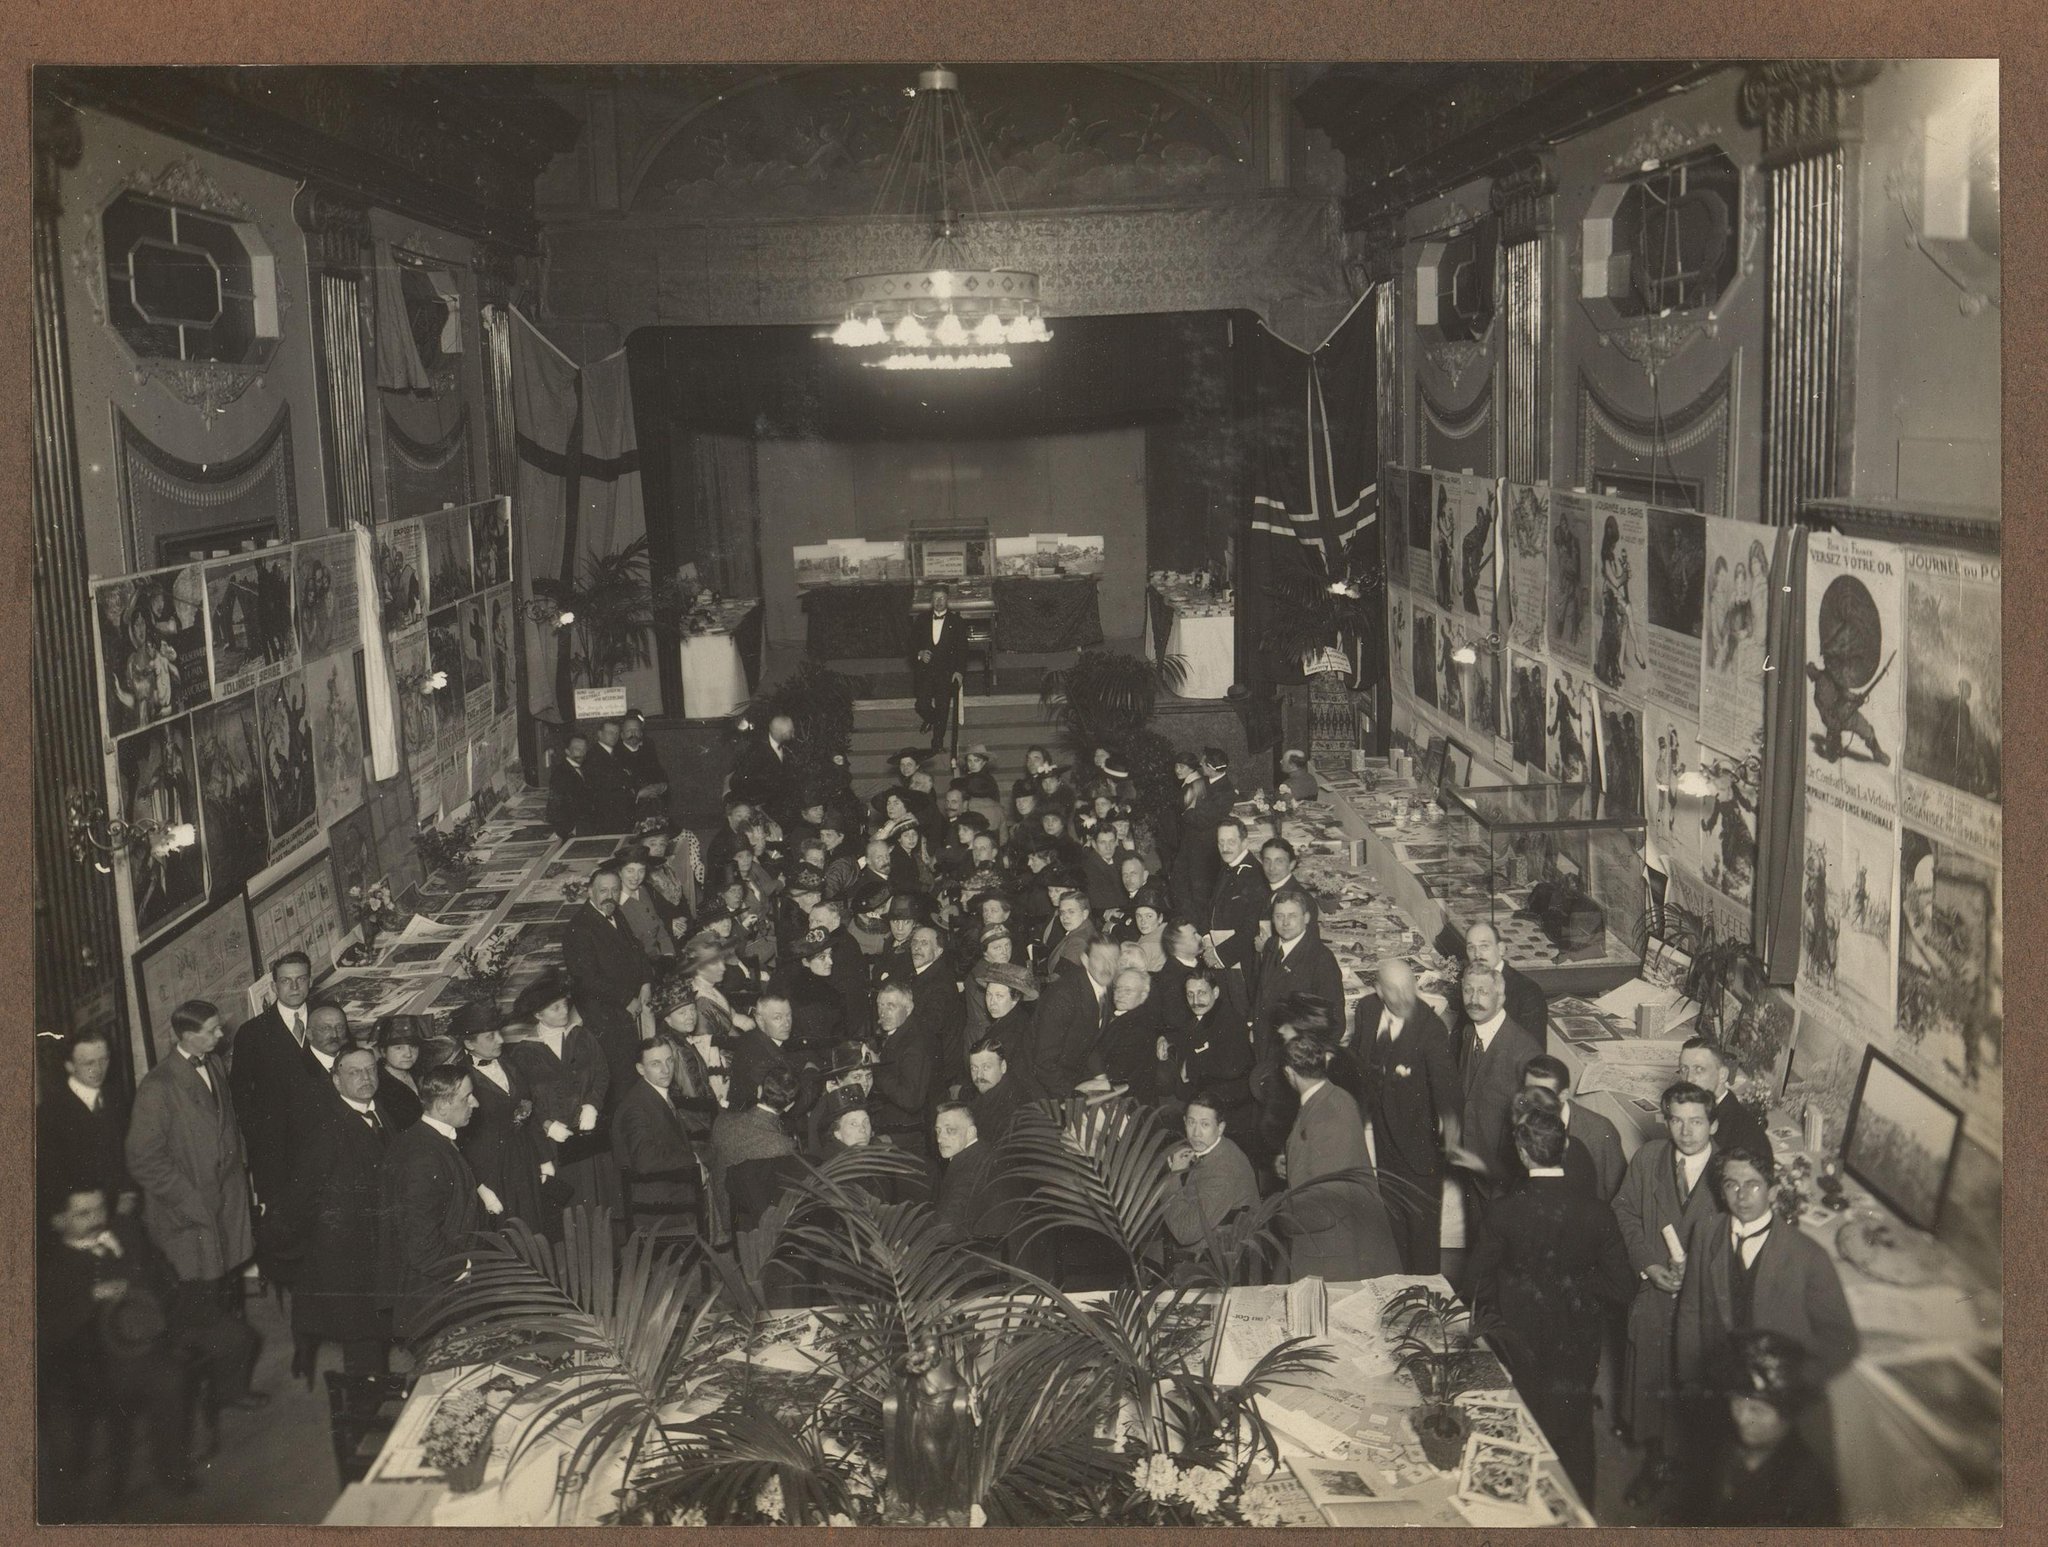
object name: photograph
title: Bond van Neutrale Landen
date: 1918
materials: photographic support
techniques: photography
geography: netherlands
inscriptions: inscription: ‘Bond van Neutrale Landen / 1918.’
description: Foto op bruin albumblad 15 van familiealbum van Alphons Diepenbrock.